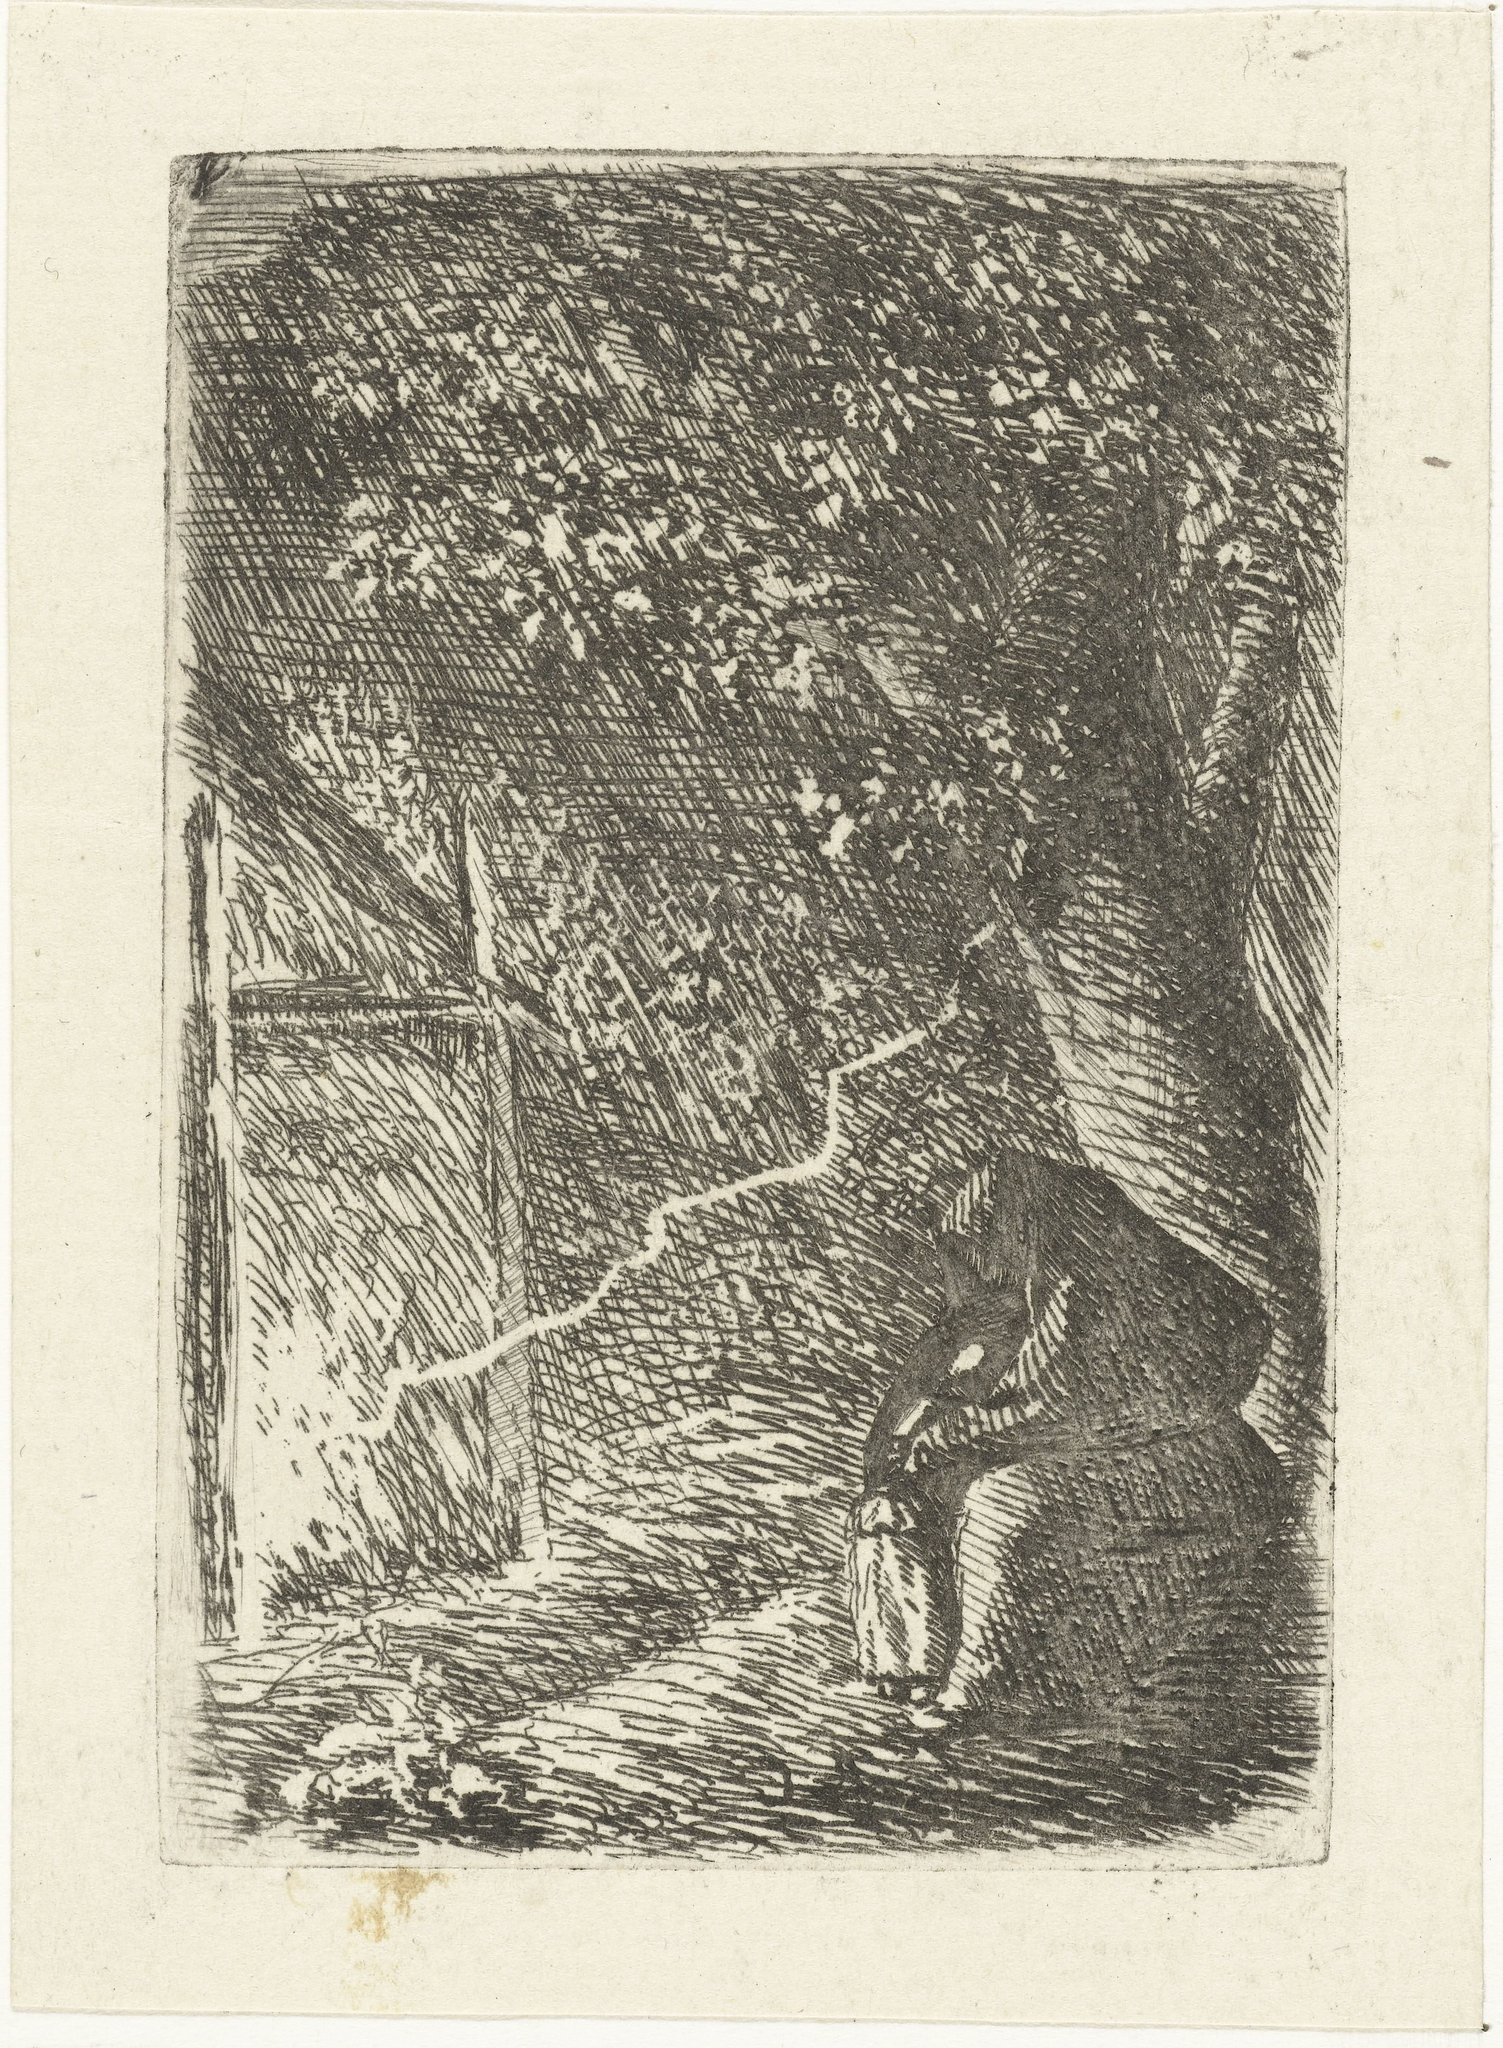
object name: print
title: Vrouw en kind schuilen voor de bliksem onder een boom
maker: louis bernard coclers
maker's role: draughtsman, print maker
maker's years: 1741-1817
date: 1756-1817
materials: paper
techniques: etching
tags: storm, accidents with lightning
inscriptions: collector's mark: Lugt 240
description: Een vrouw en een kind schuilen onder een grote boom terwijl de bliksem inslaat in een huistapel naast hen.